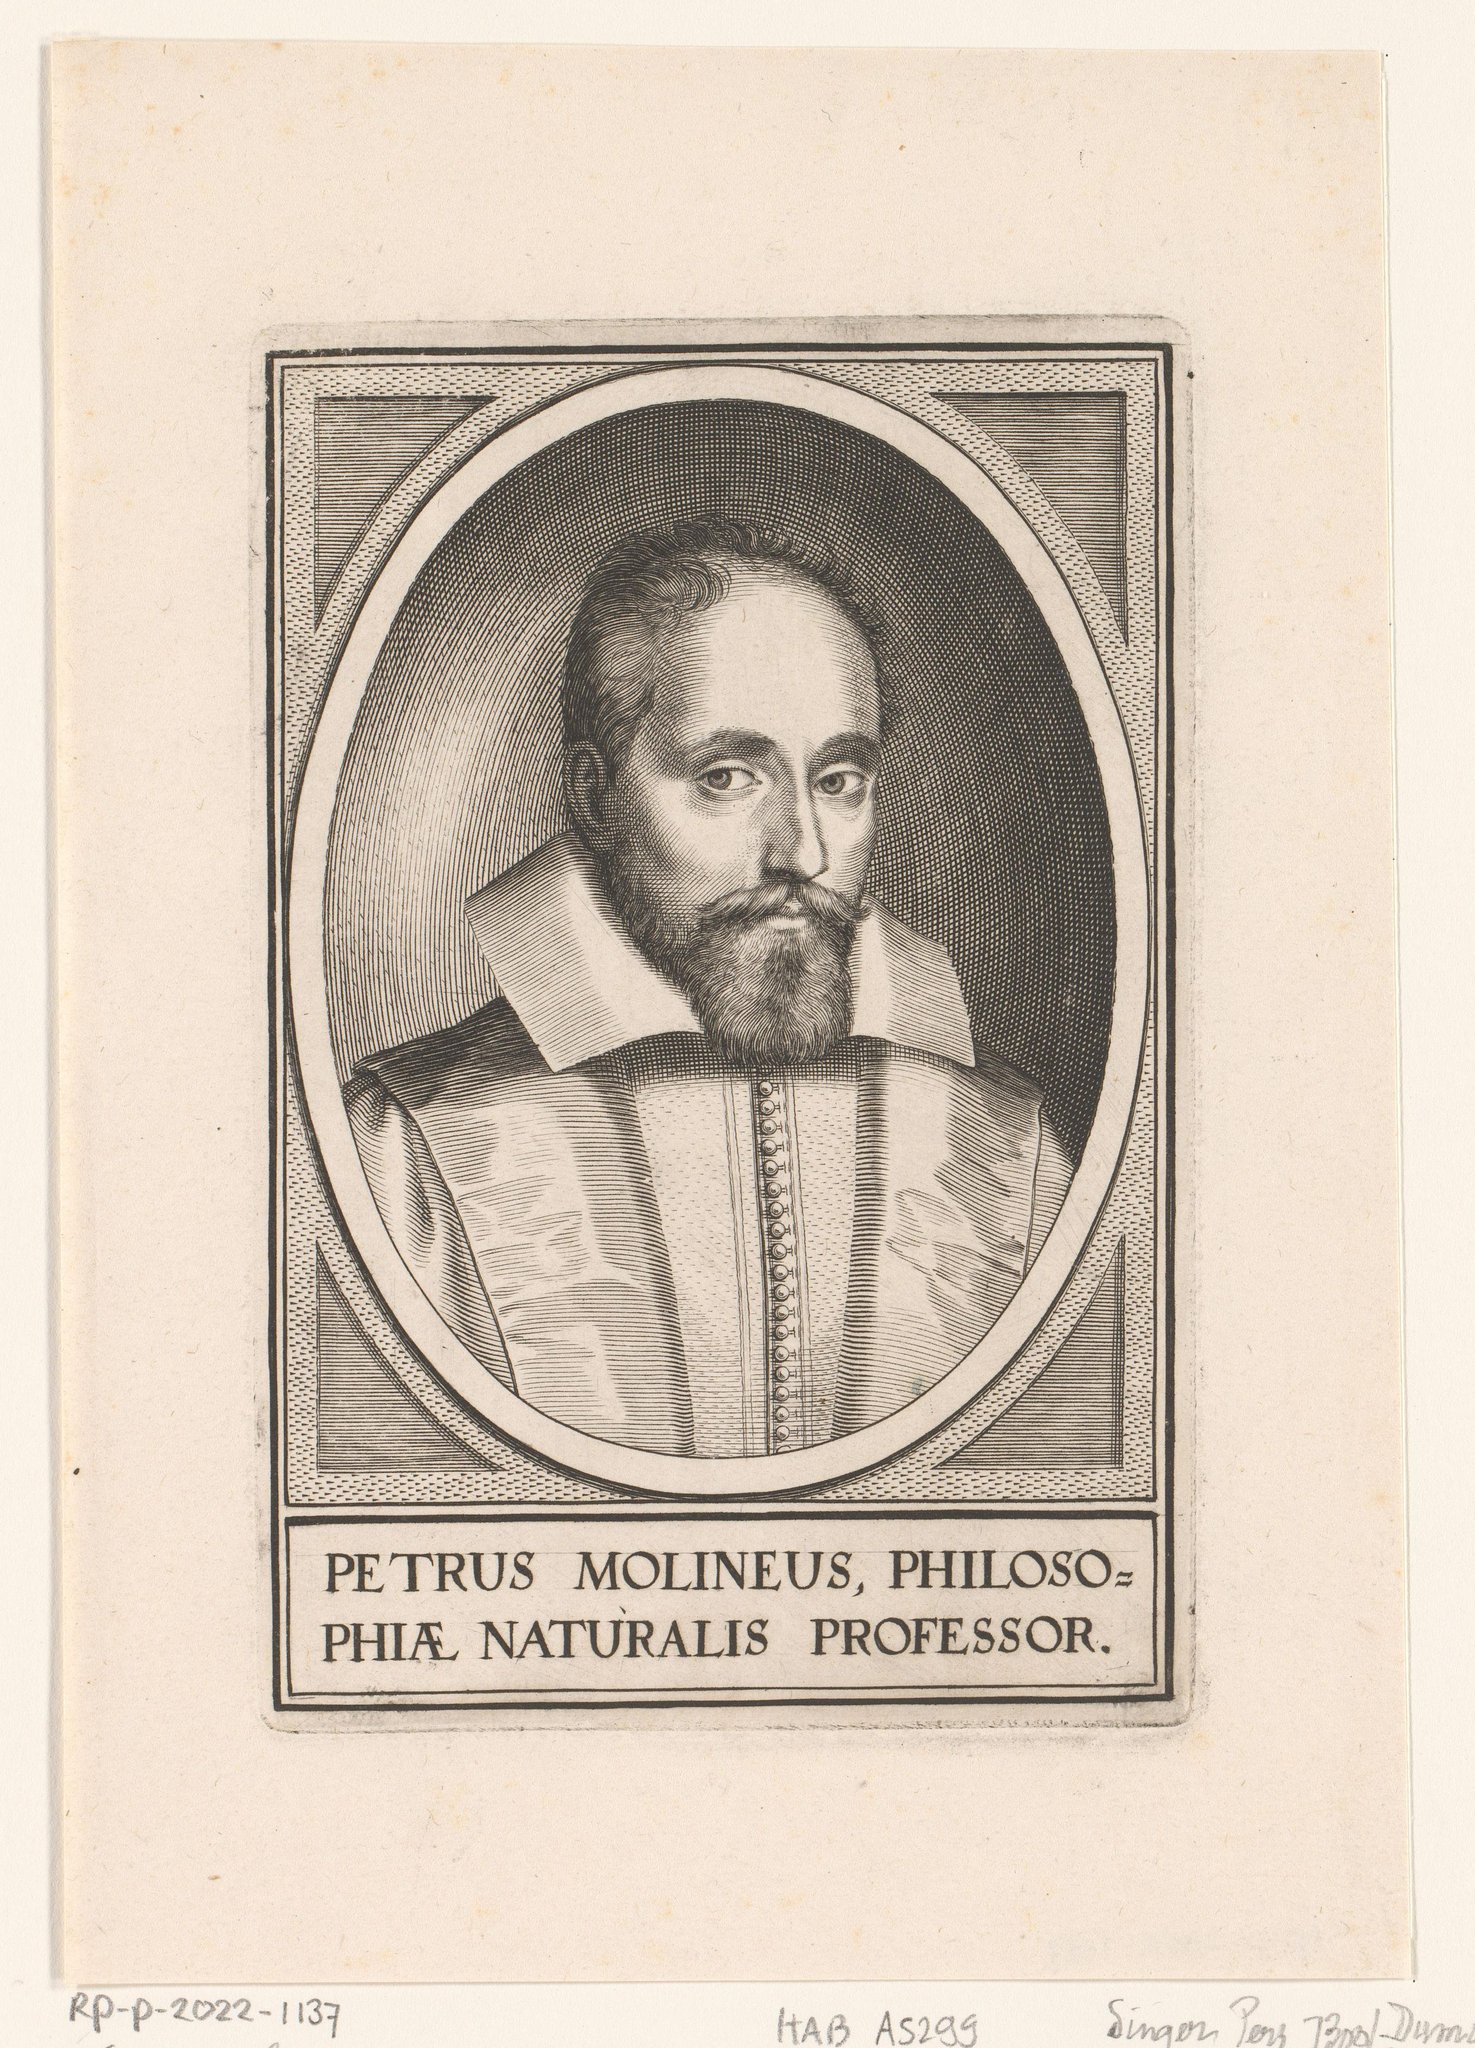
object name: print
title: Portret van Pierre du Moulin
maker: Anonymous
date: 1600-1750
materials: paper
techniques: etching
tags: minister ~ government, historical persons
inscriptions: collector's mark: Lugt 2228